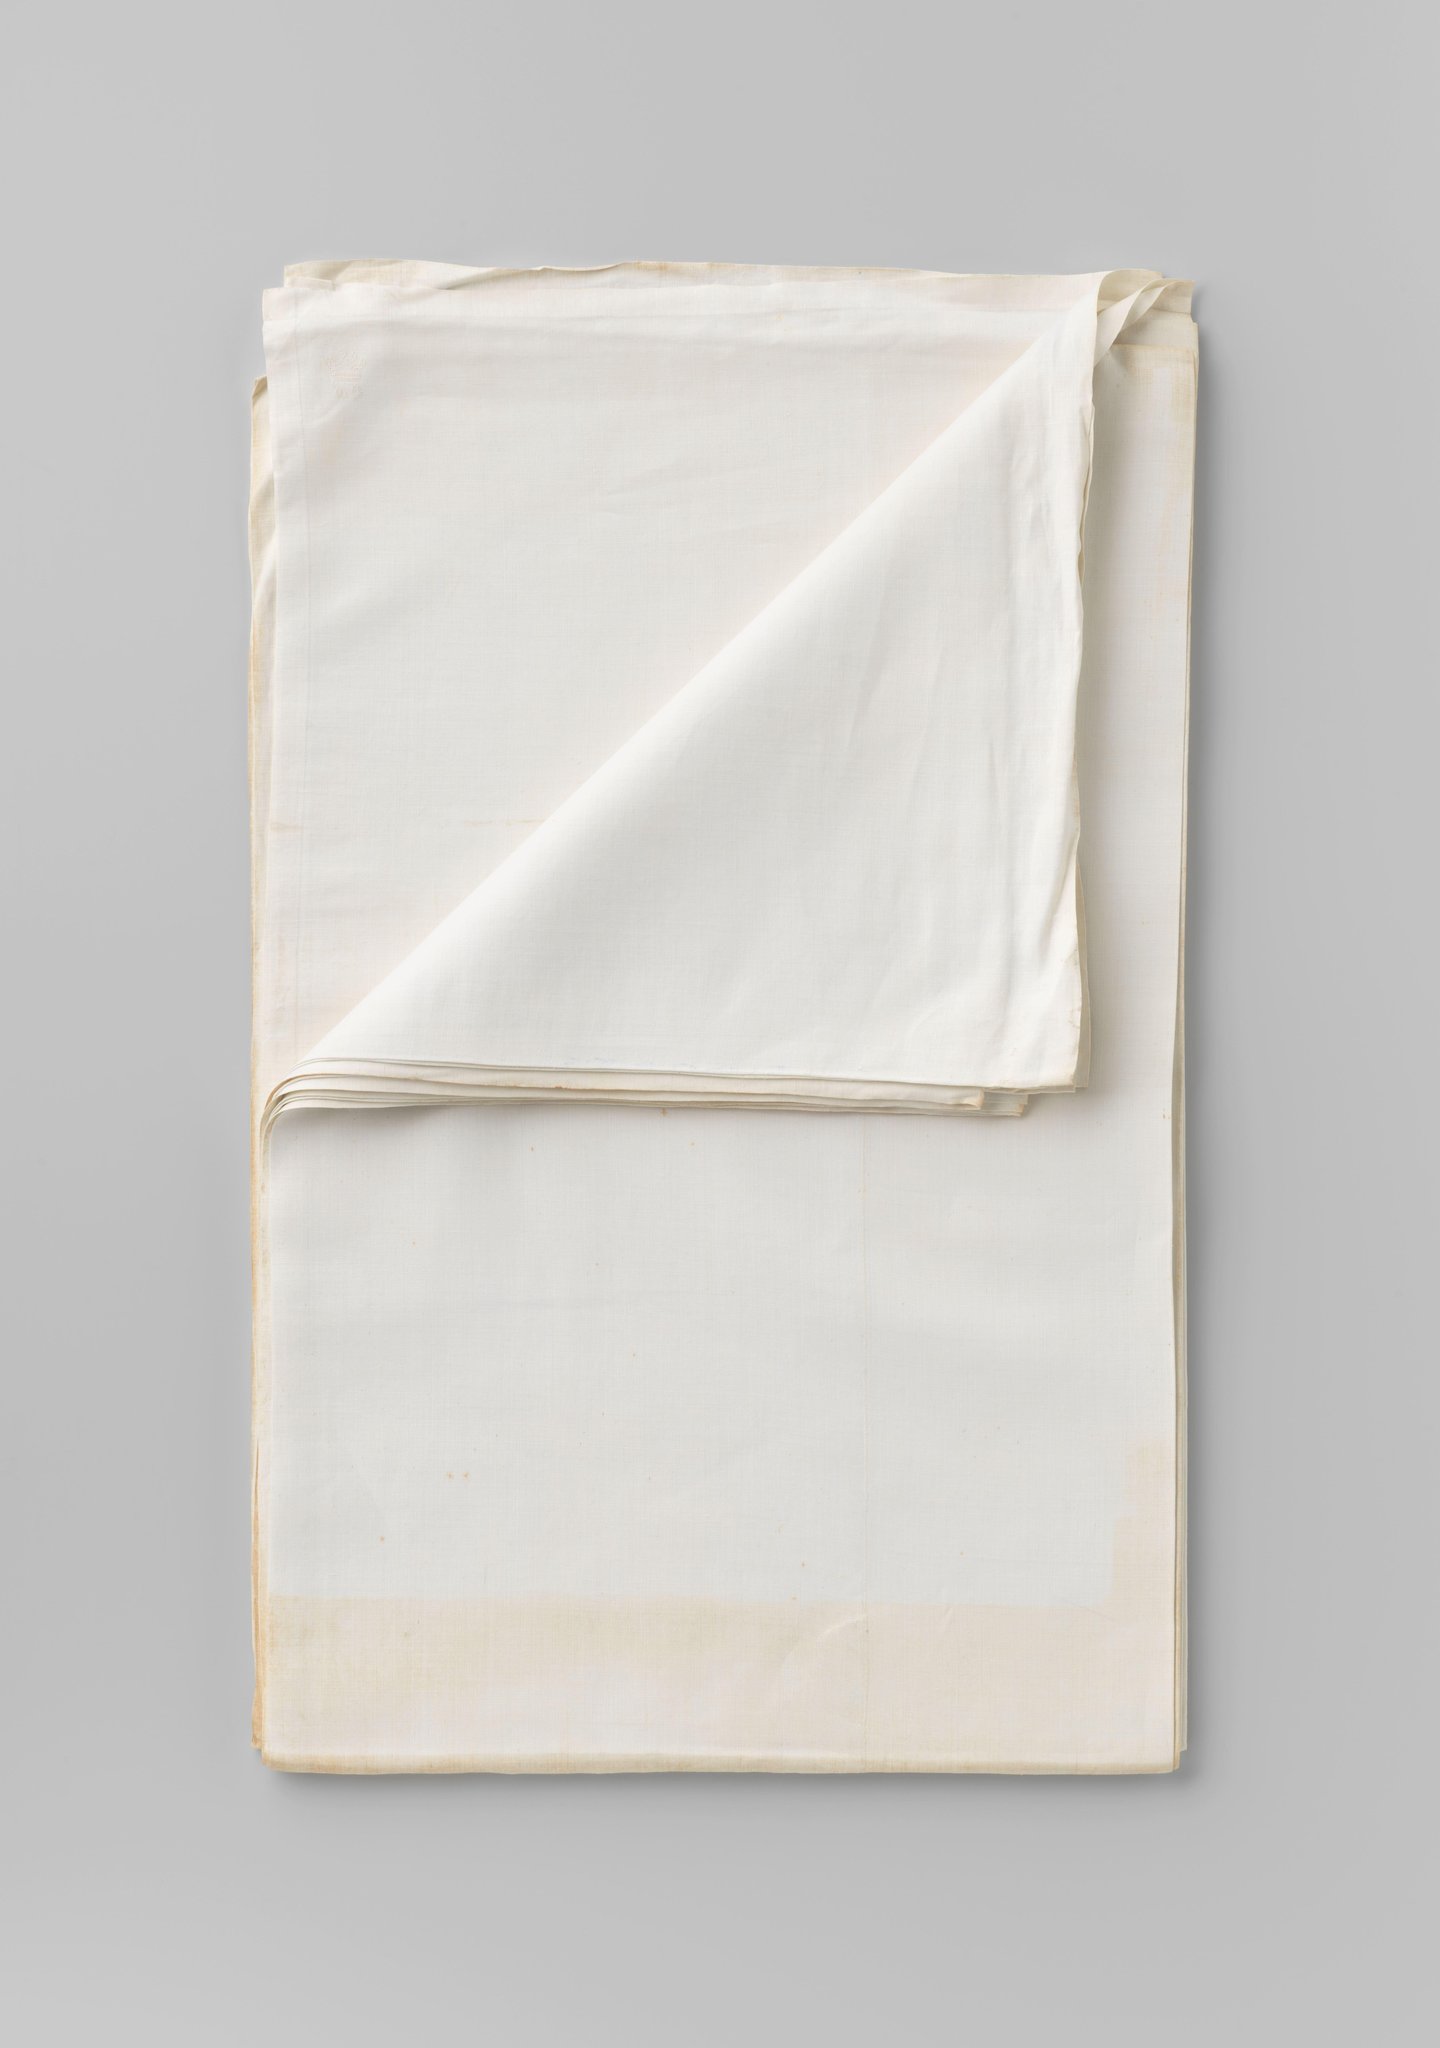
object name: beddenlaken, laken object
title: Laken. Merk: kroon WG, HW 21 en jaartal 1728.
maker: Anonymous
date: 1728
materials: linen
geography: northern netherlands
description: Laken van wit linnen, merk kroon WG en jaartal 1728 en HW 2 1